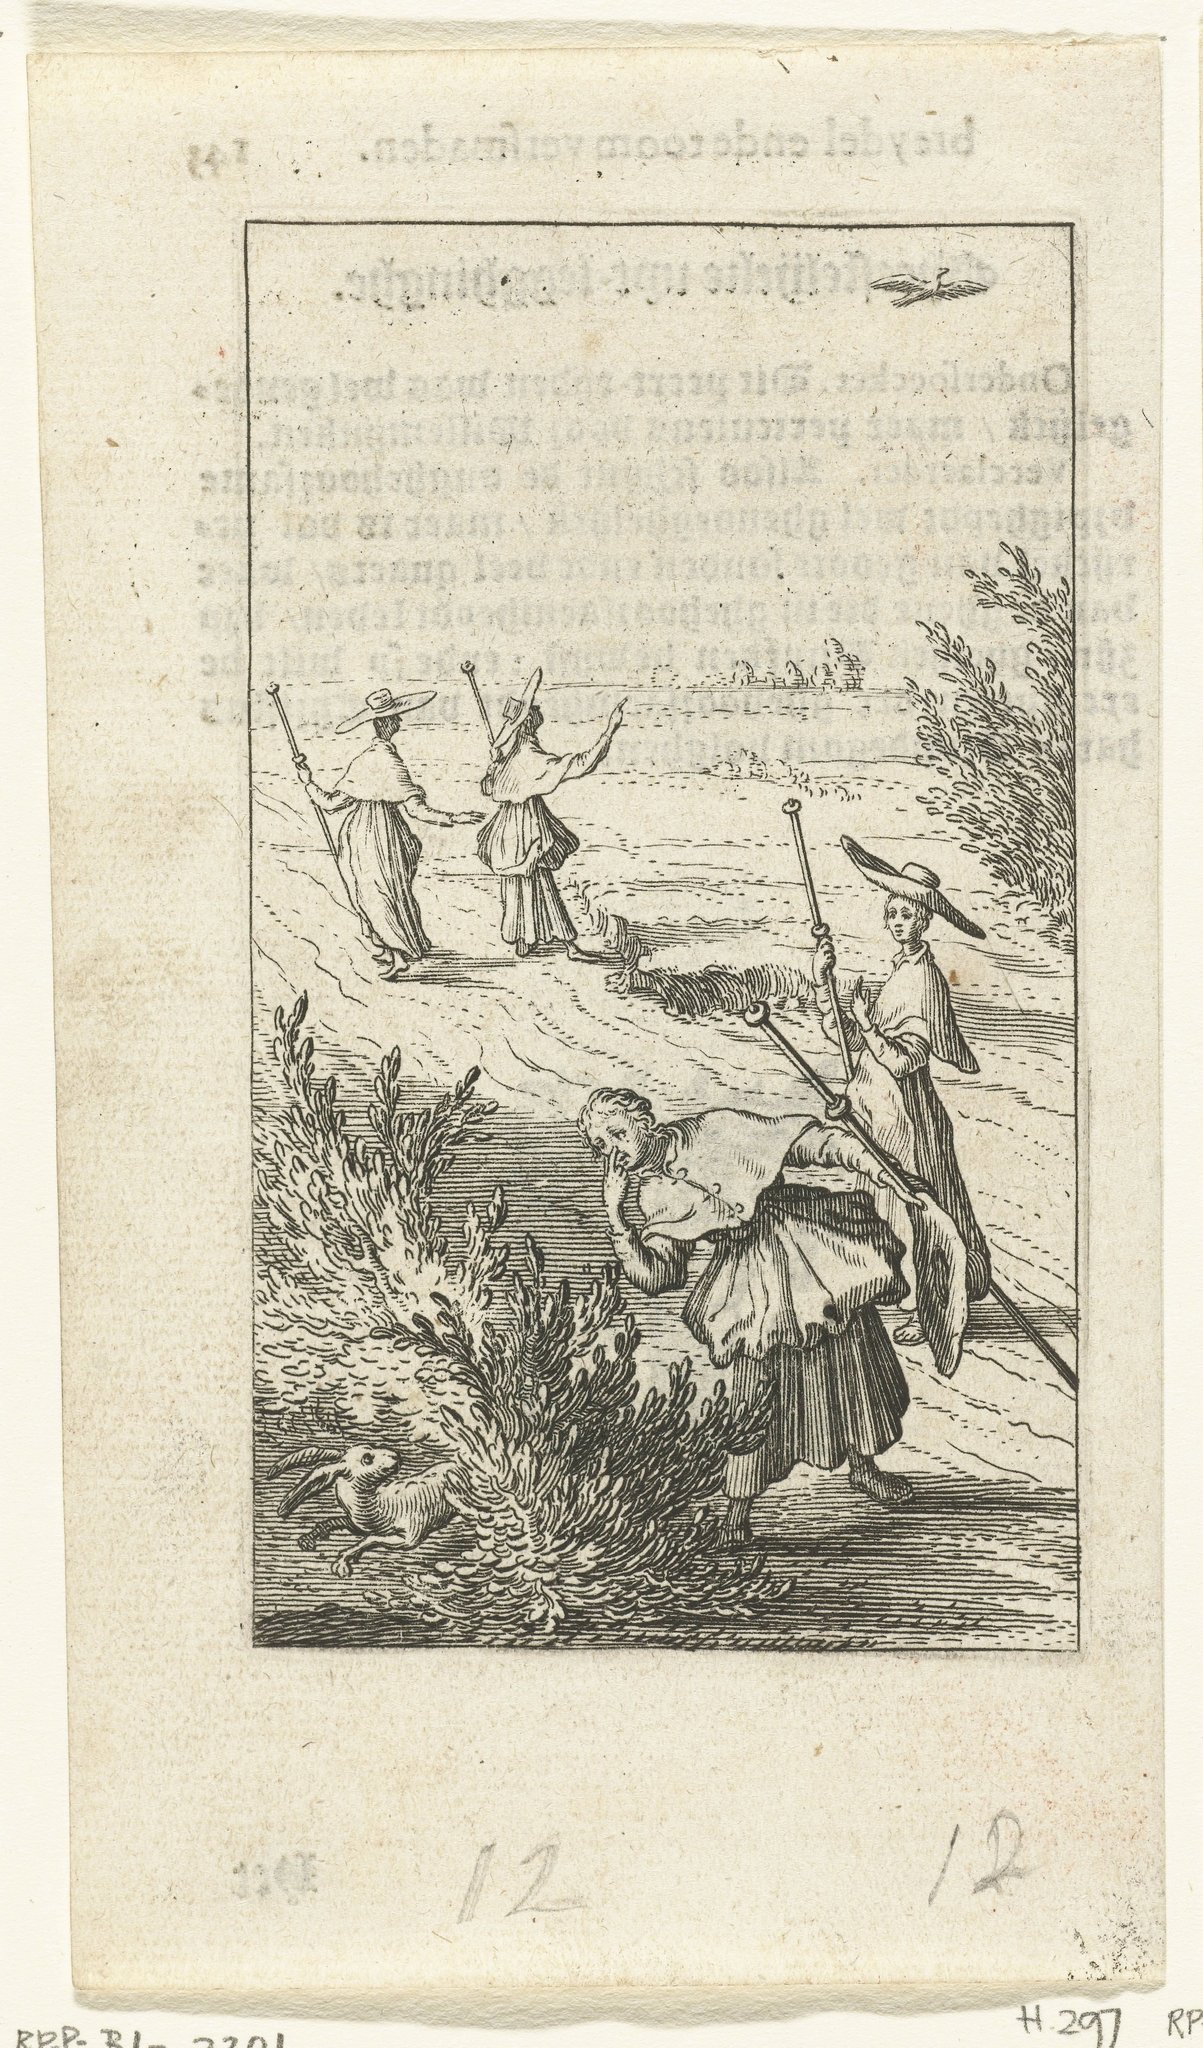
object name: book illustration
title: Duyfkens en Willemynkens pelgrimagie tot haren beminden binnen Iervsalem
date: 1590-1627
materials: paper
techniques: engraving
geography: antwerp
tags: pilgrimage, pilgrim(s) under way, rodents: rabbit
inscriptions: collector's mark: Lugt 2228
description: Prent uit: Boëtius Adamsz. Bolswert, Duyfkens en Willemynkens pelgrimagie tot haren beminden binnen Iervsalem. Haerlieder teghenspoet, belet en eynde, Antwerpen, Hendrick Aertssens, 1638. Op het verso staat een verklarende Nederlandse tekst bij de voorgaande illustratie in dit devotie boekje (vergelijk RP-P-BI-2200).